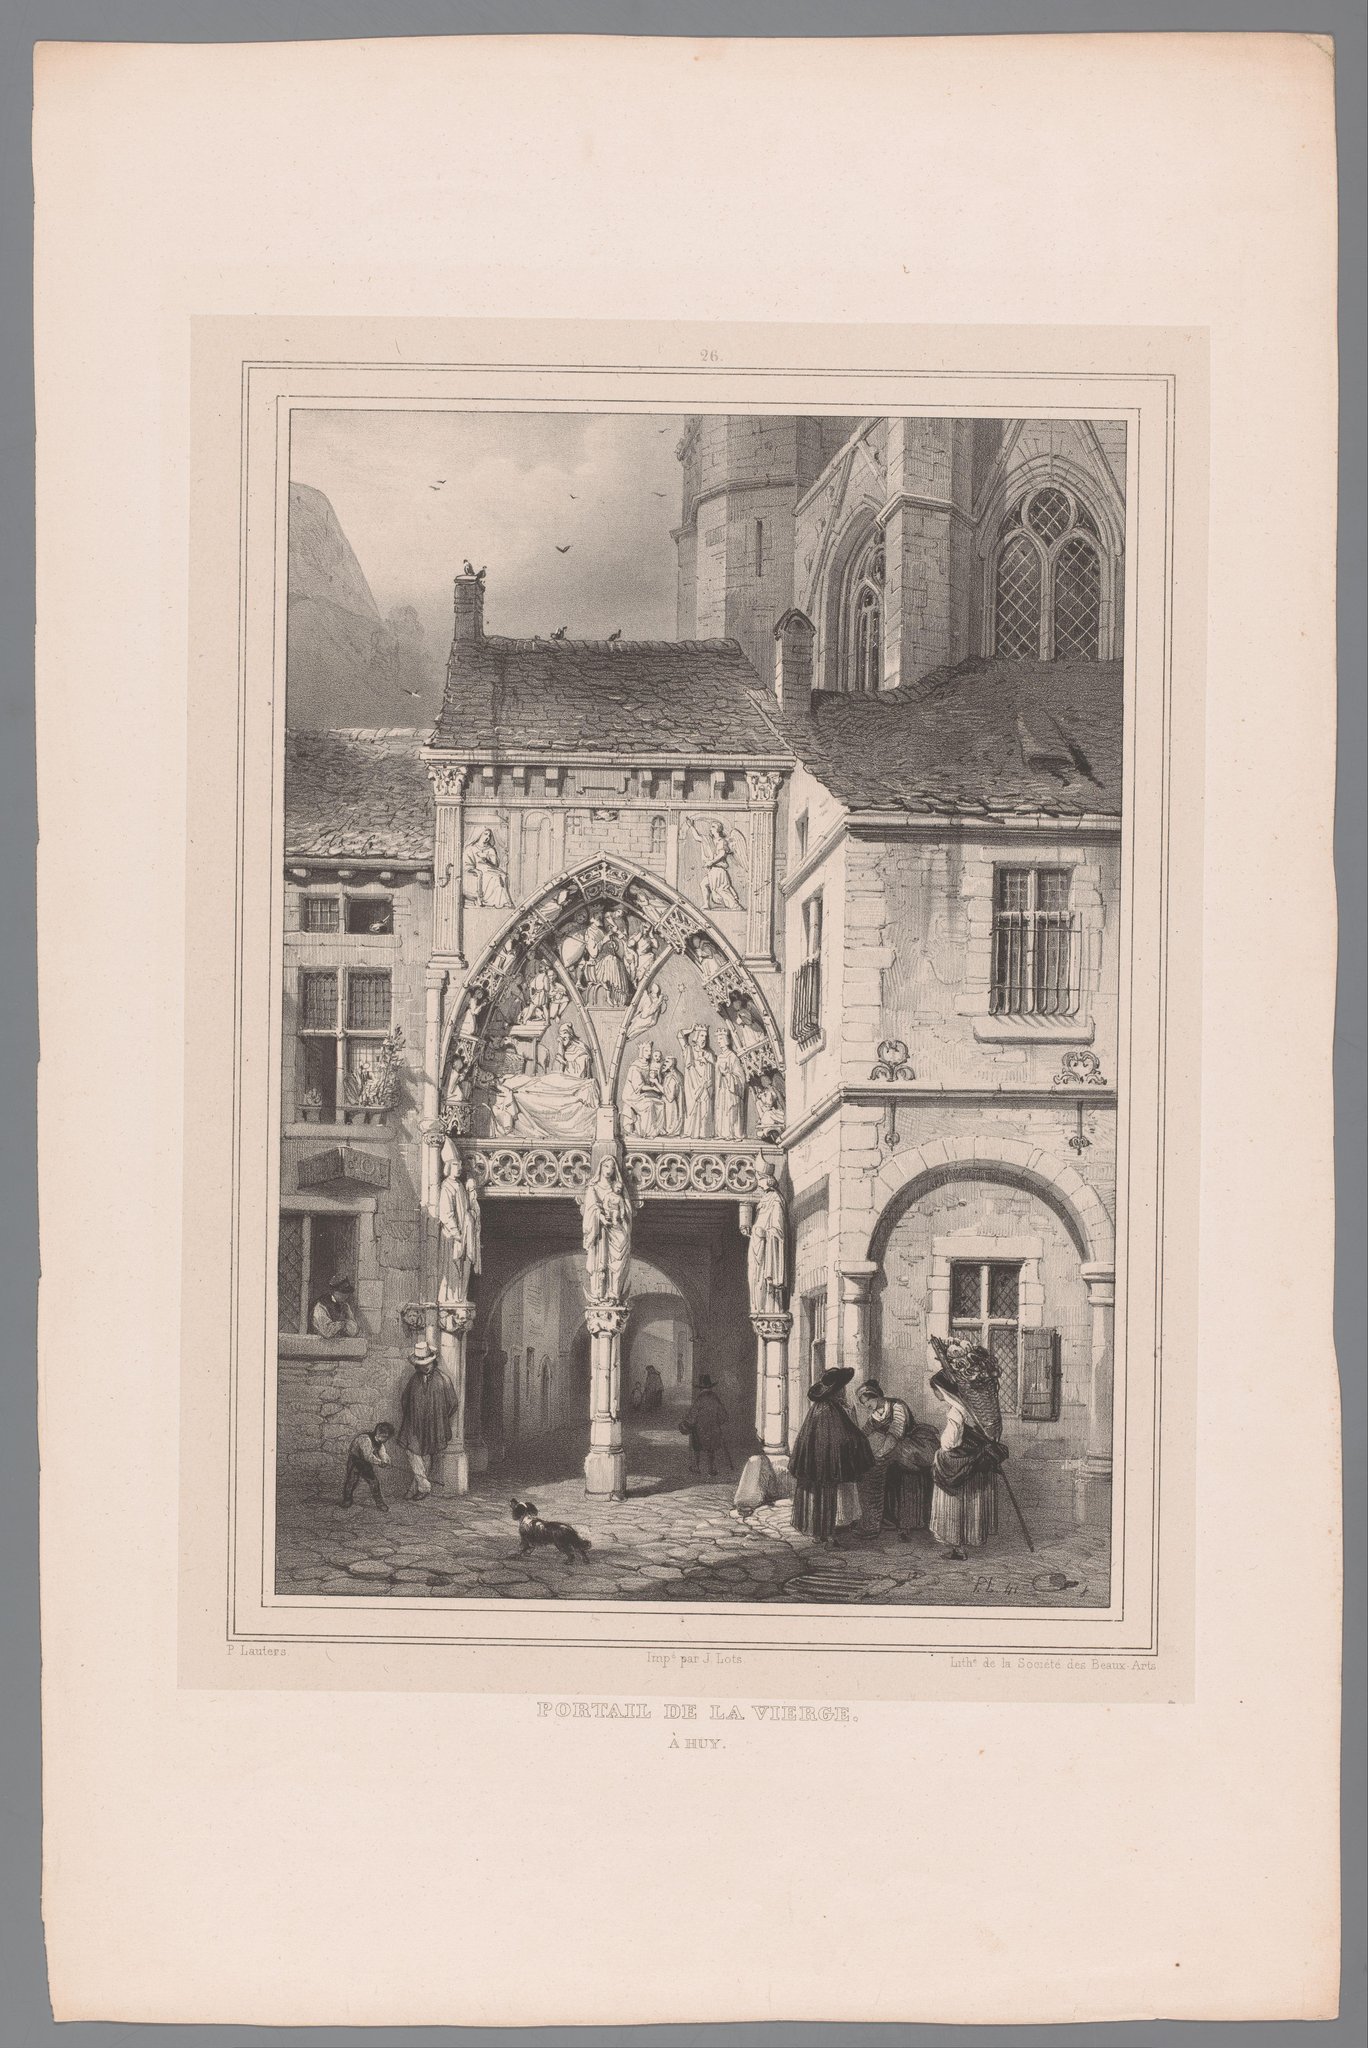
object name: print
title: Portaal van de Collegiale kerk Onze-Lieve-Vrouw en Domitianus van Hoei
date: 1839-1841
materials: paper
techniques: lithograph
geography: brussels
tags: parts of church exterior and annexes: portal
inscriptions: collector's mark: Lugt 2228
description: Prent verschenen in: Van Hasselt, André. Voyage aux bords de la Meuse. Brussel: Société des Beaux-Arts, 1839-1841. Deze publicatie bevat 36 litho's.